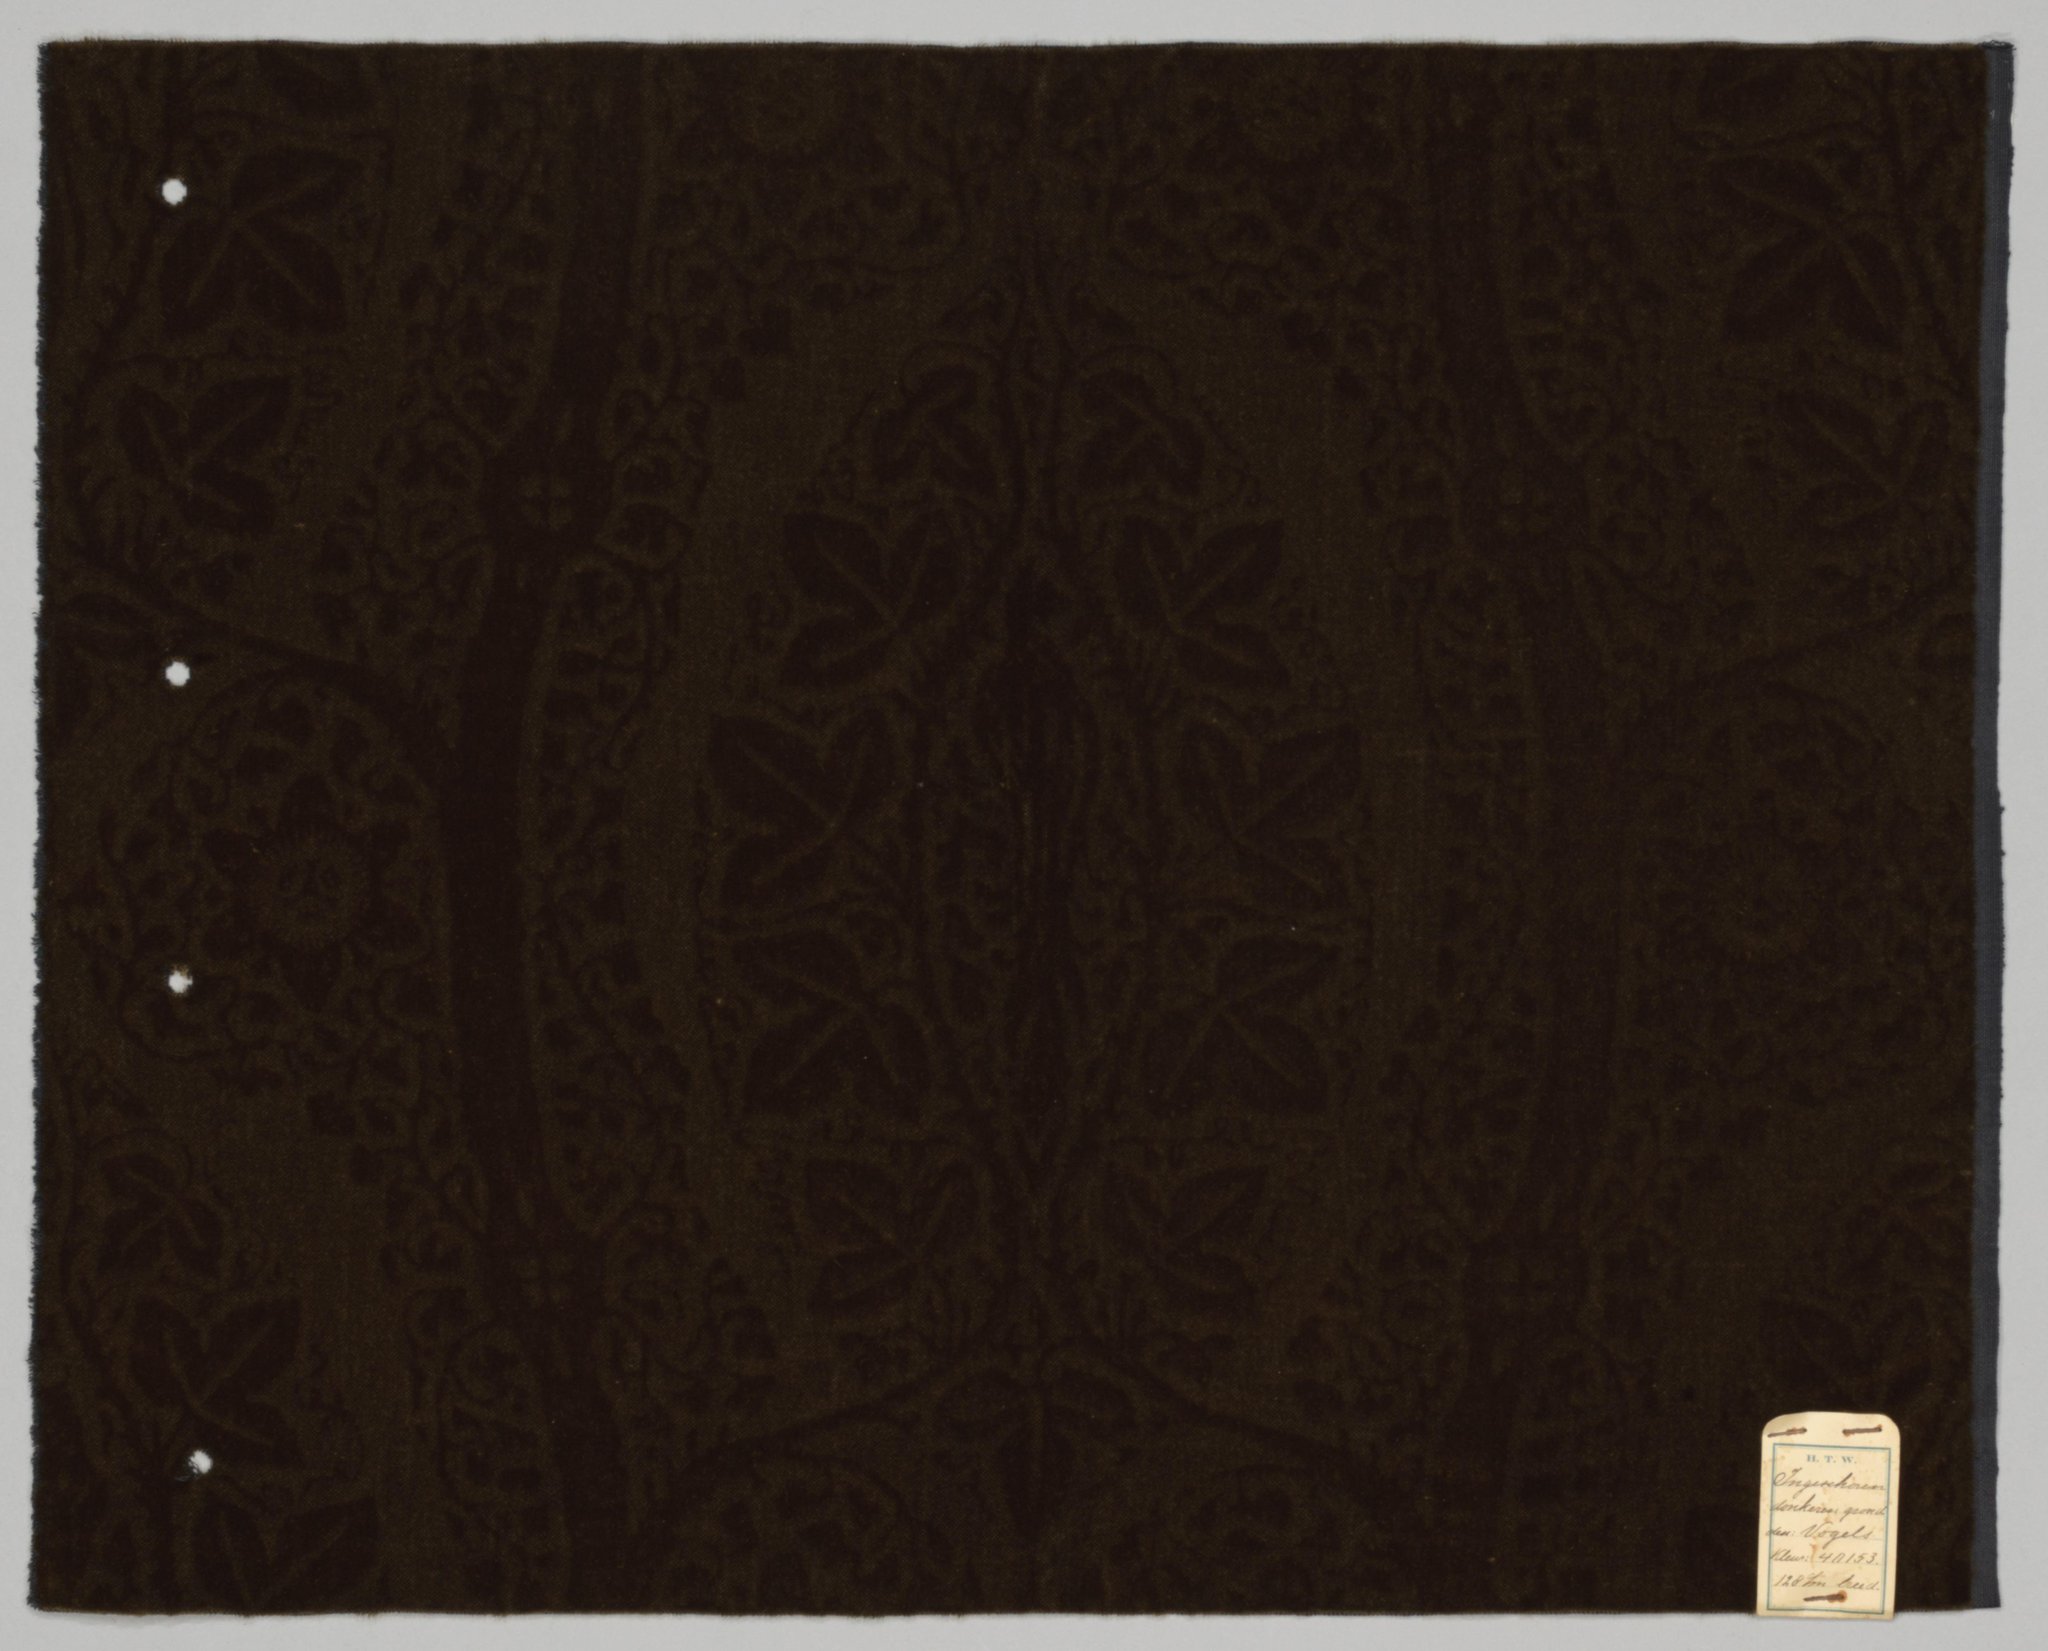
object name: sample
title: Fragment ingeschoren trijp met patroon van takken waarbinnen door bladeren omkranst ovaal met vogel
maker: theo nieuwenhuis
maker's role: designer, draughtsman, print maker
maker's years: 1866-1951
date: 1909-1920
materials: cotton, hair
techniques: shaving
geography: hengelo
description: Fragment van bruingroen geschoren trijp met een patroon van fijne takken, waarbinnen een door bladeren omkranst ovaal met een vogel.